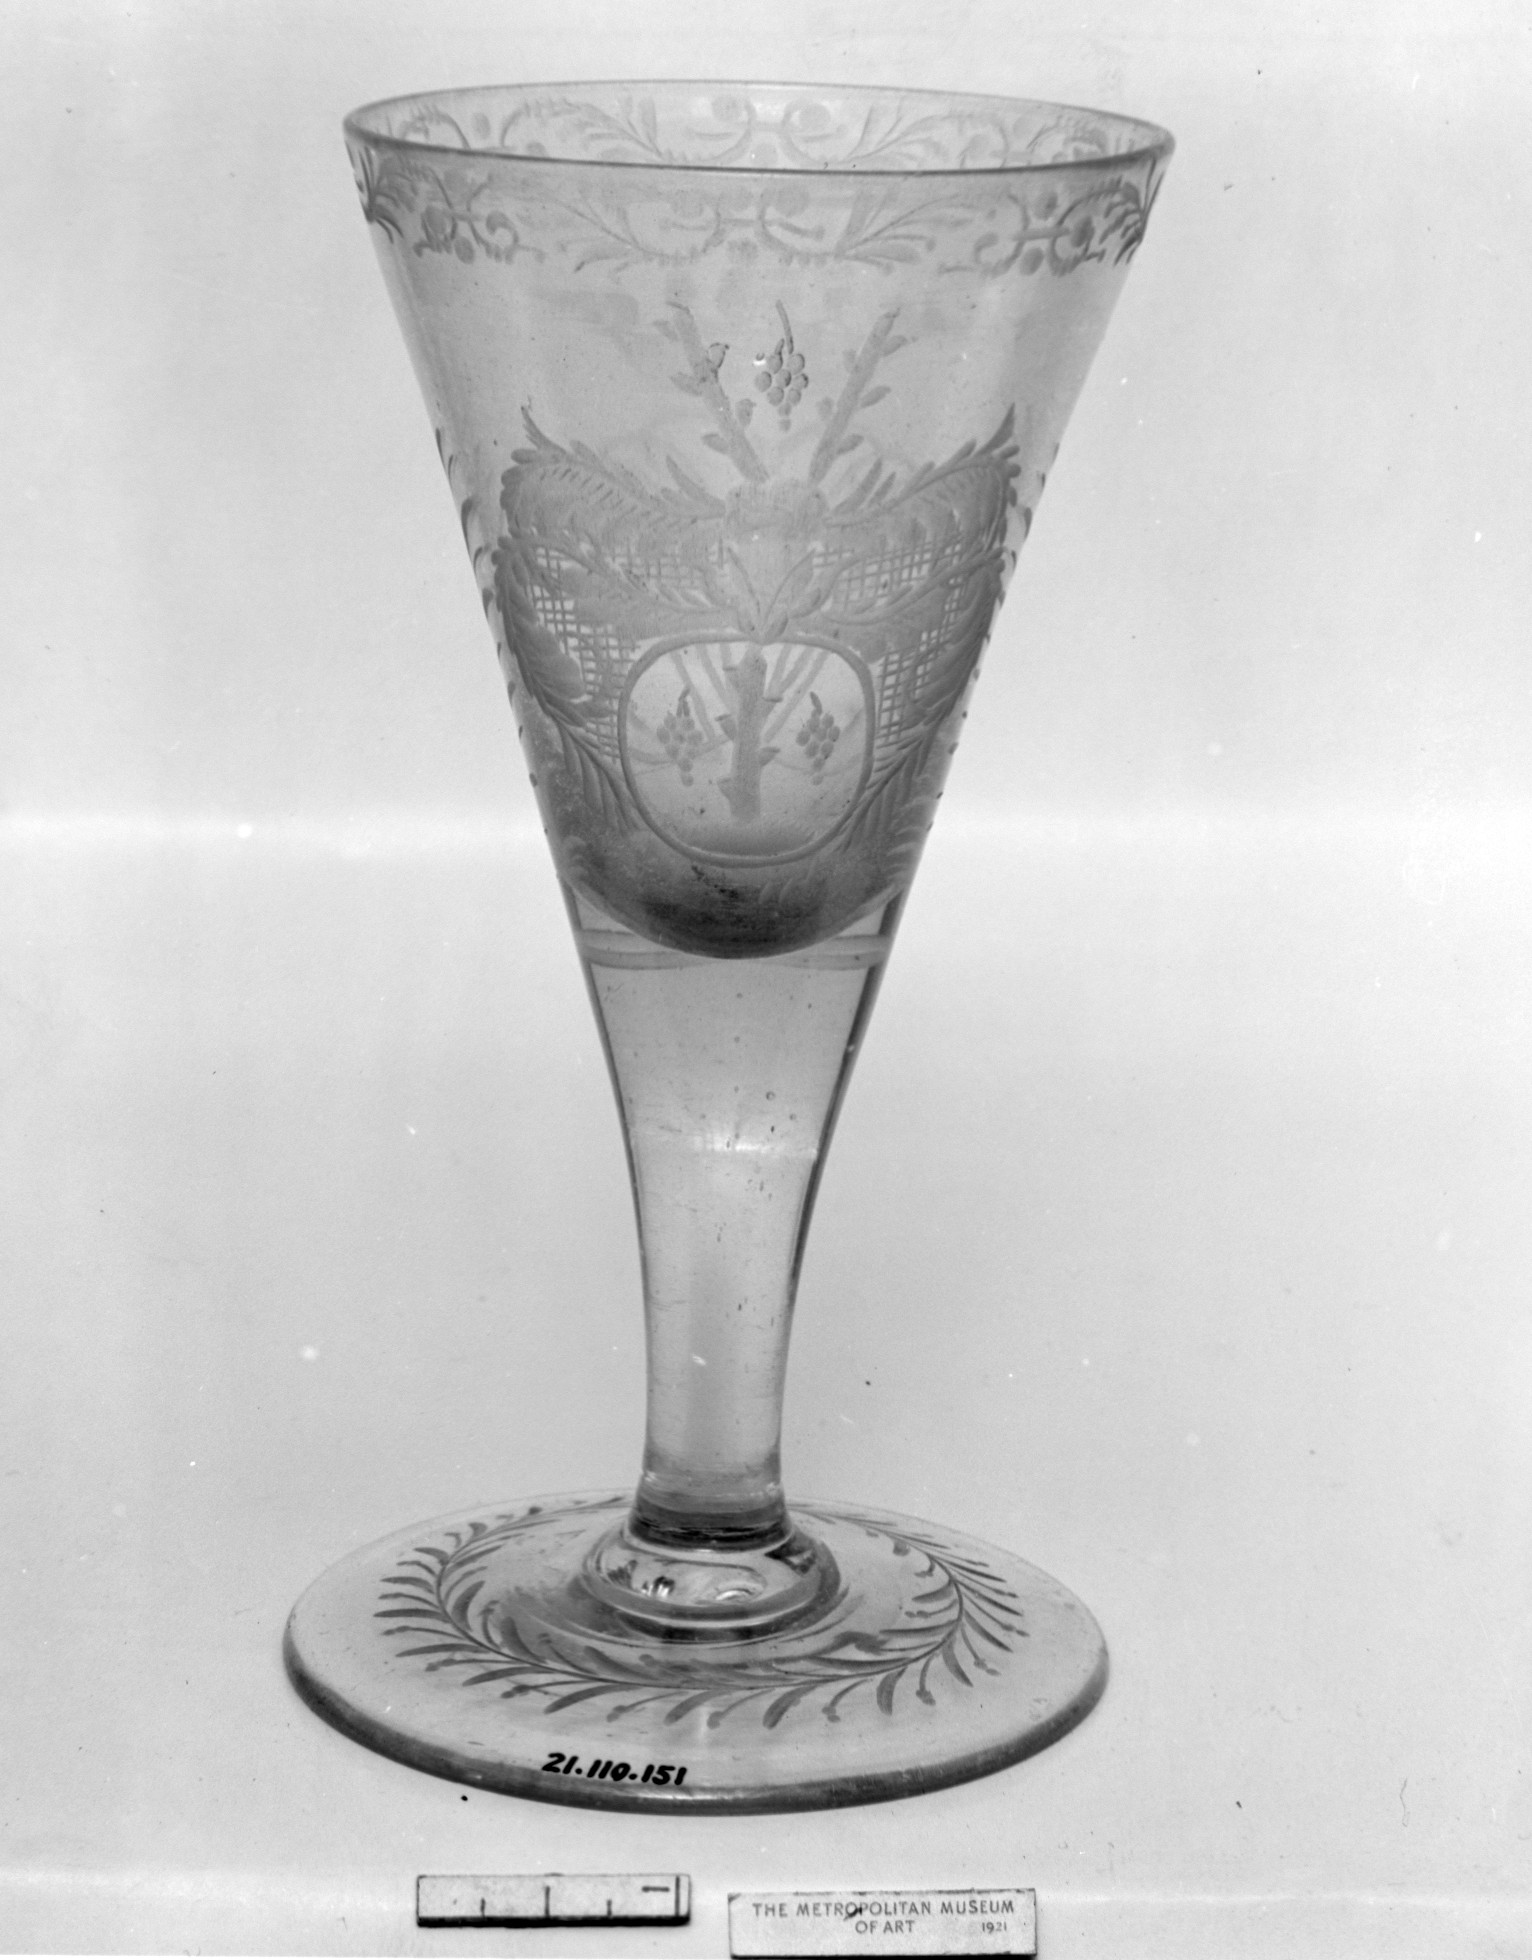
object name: wineglass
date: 1701-1733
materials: glass